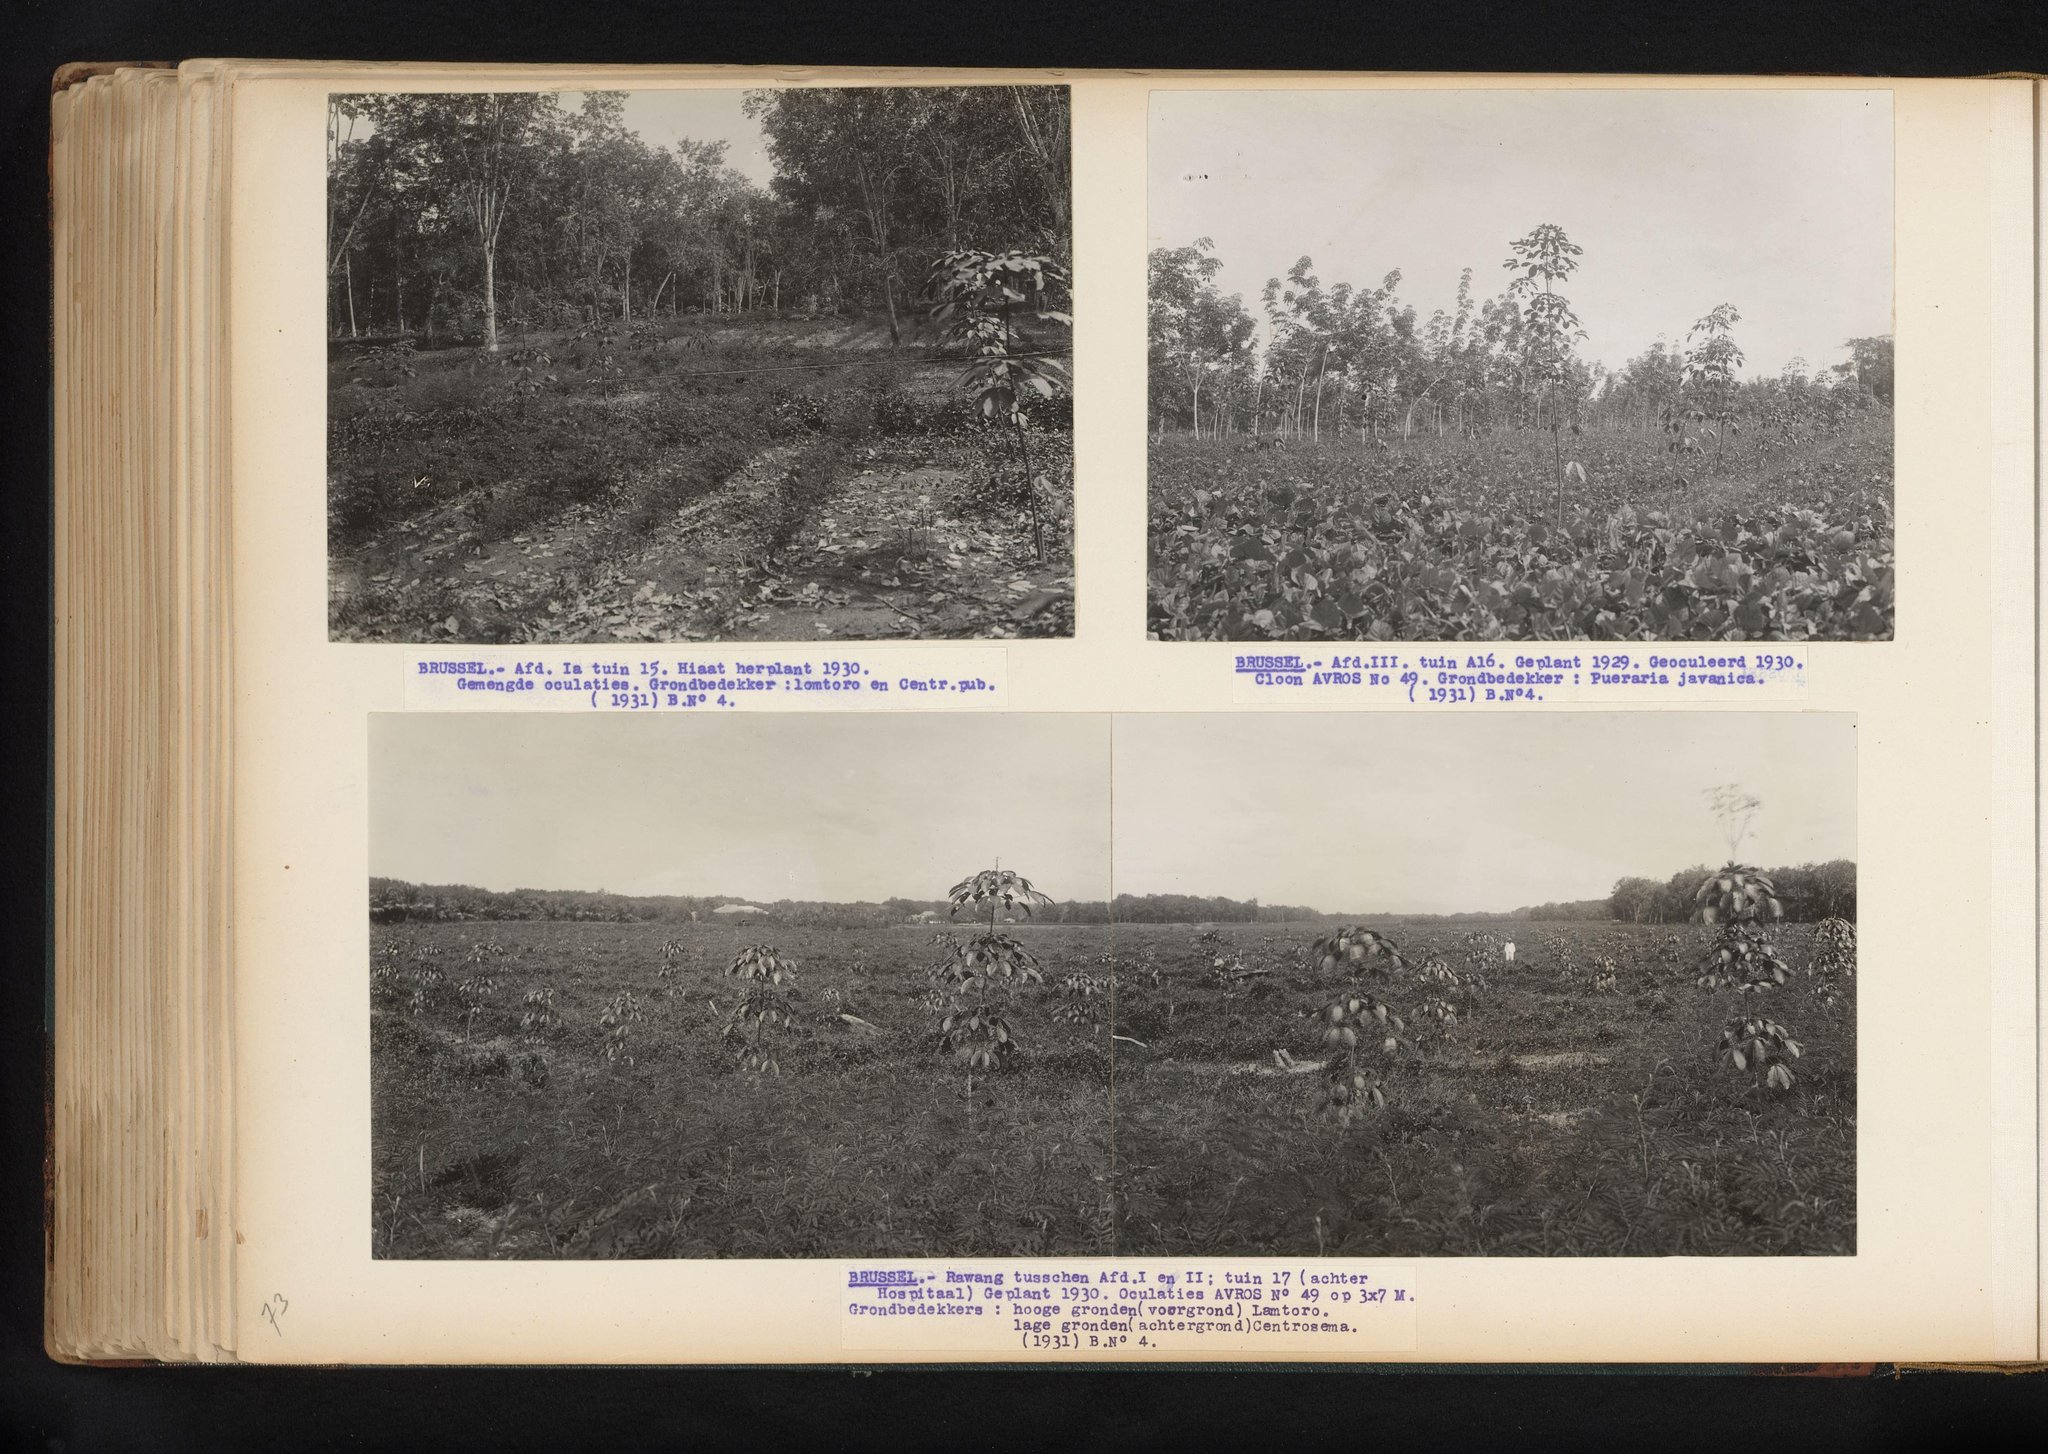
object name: album leaf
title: Koffiecultuur op Brussel, 1931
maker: Anonymous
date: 1931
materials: cardboard, photographic support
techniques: gelatin silver print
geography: sumatra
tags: plantation, fruits: coffee, sumatra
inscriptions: inscription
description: Blad met drie foto's van koffieplanten en bodembedekkers op Brussel, 1931. Onder de foto's etiketten met onderschriften. Onderdeel van het fotoalbum over de plantages Brussel en Pernantian van de Sumatra Caoutchouc Maatschappij op de Oostkust van Sumatra in de jaren 1910-1935.